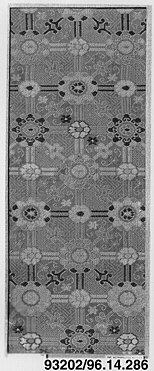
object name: piece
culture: japanese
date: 1701-1900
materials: silk